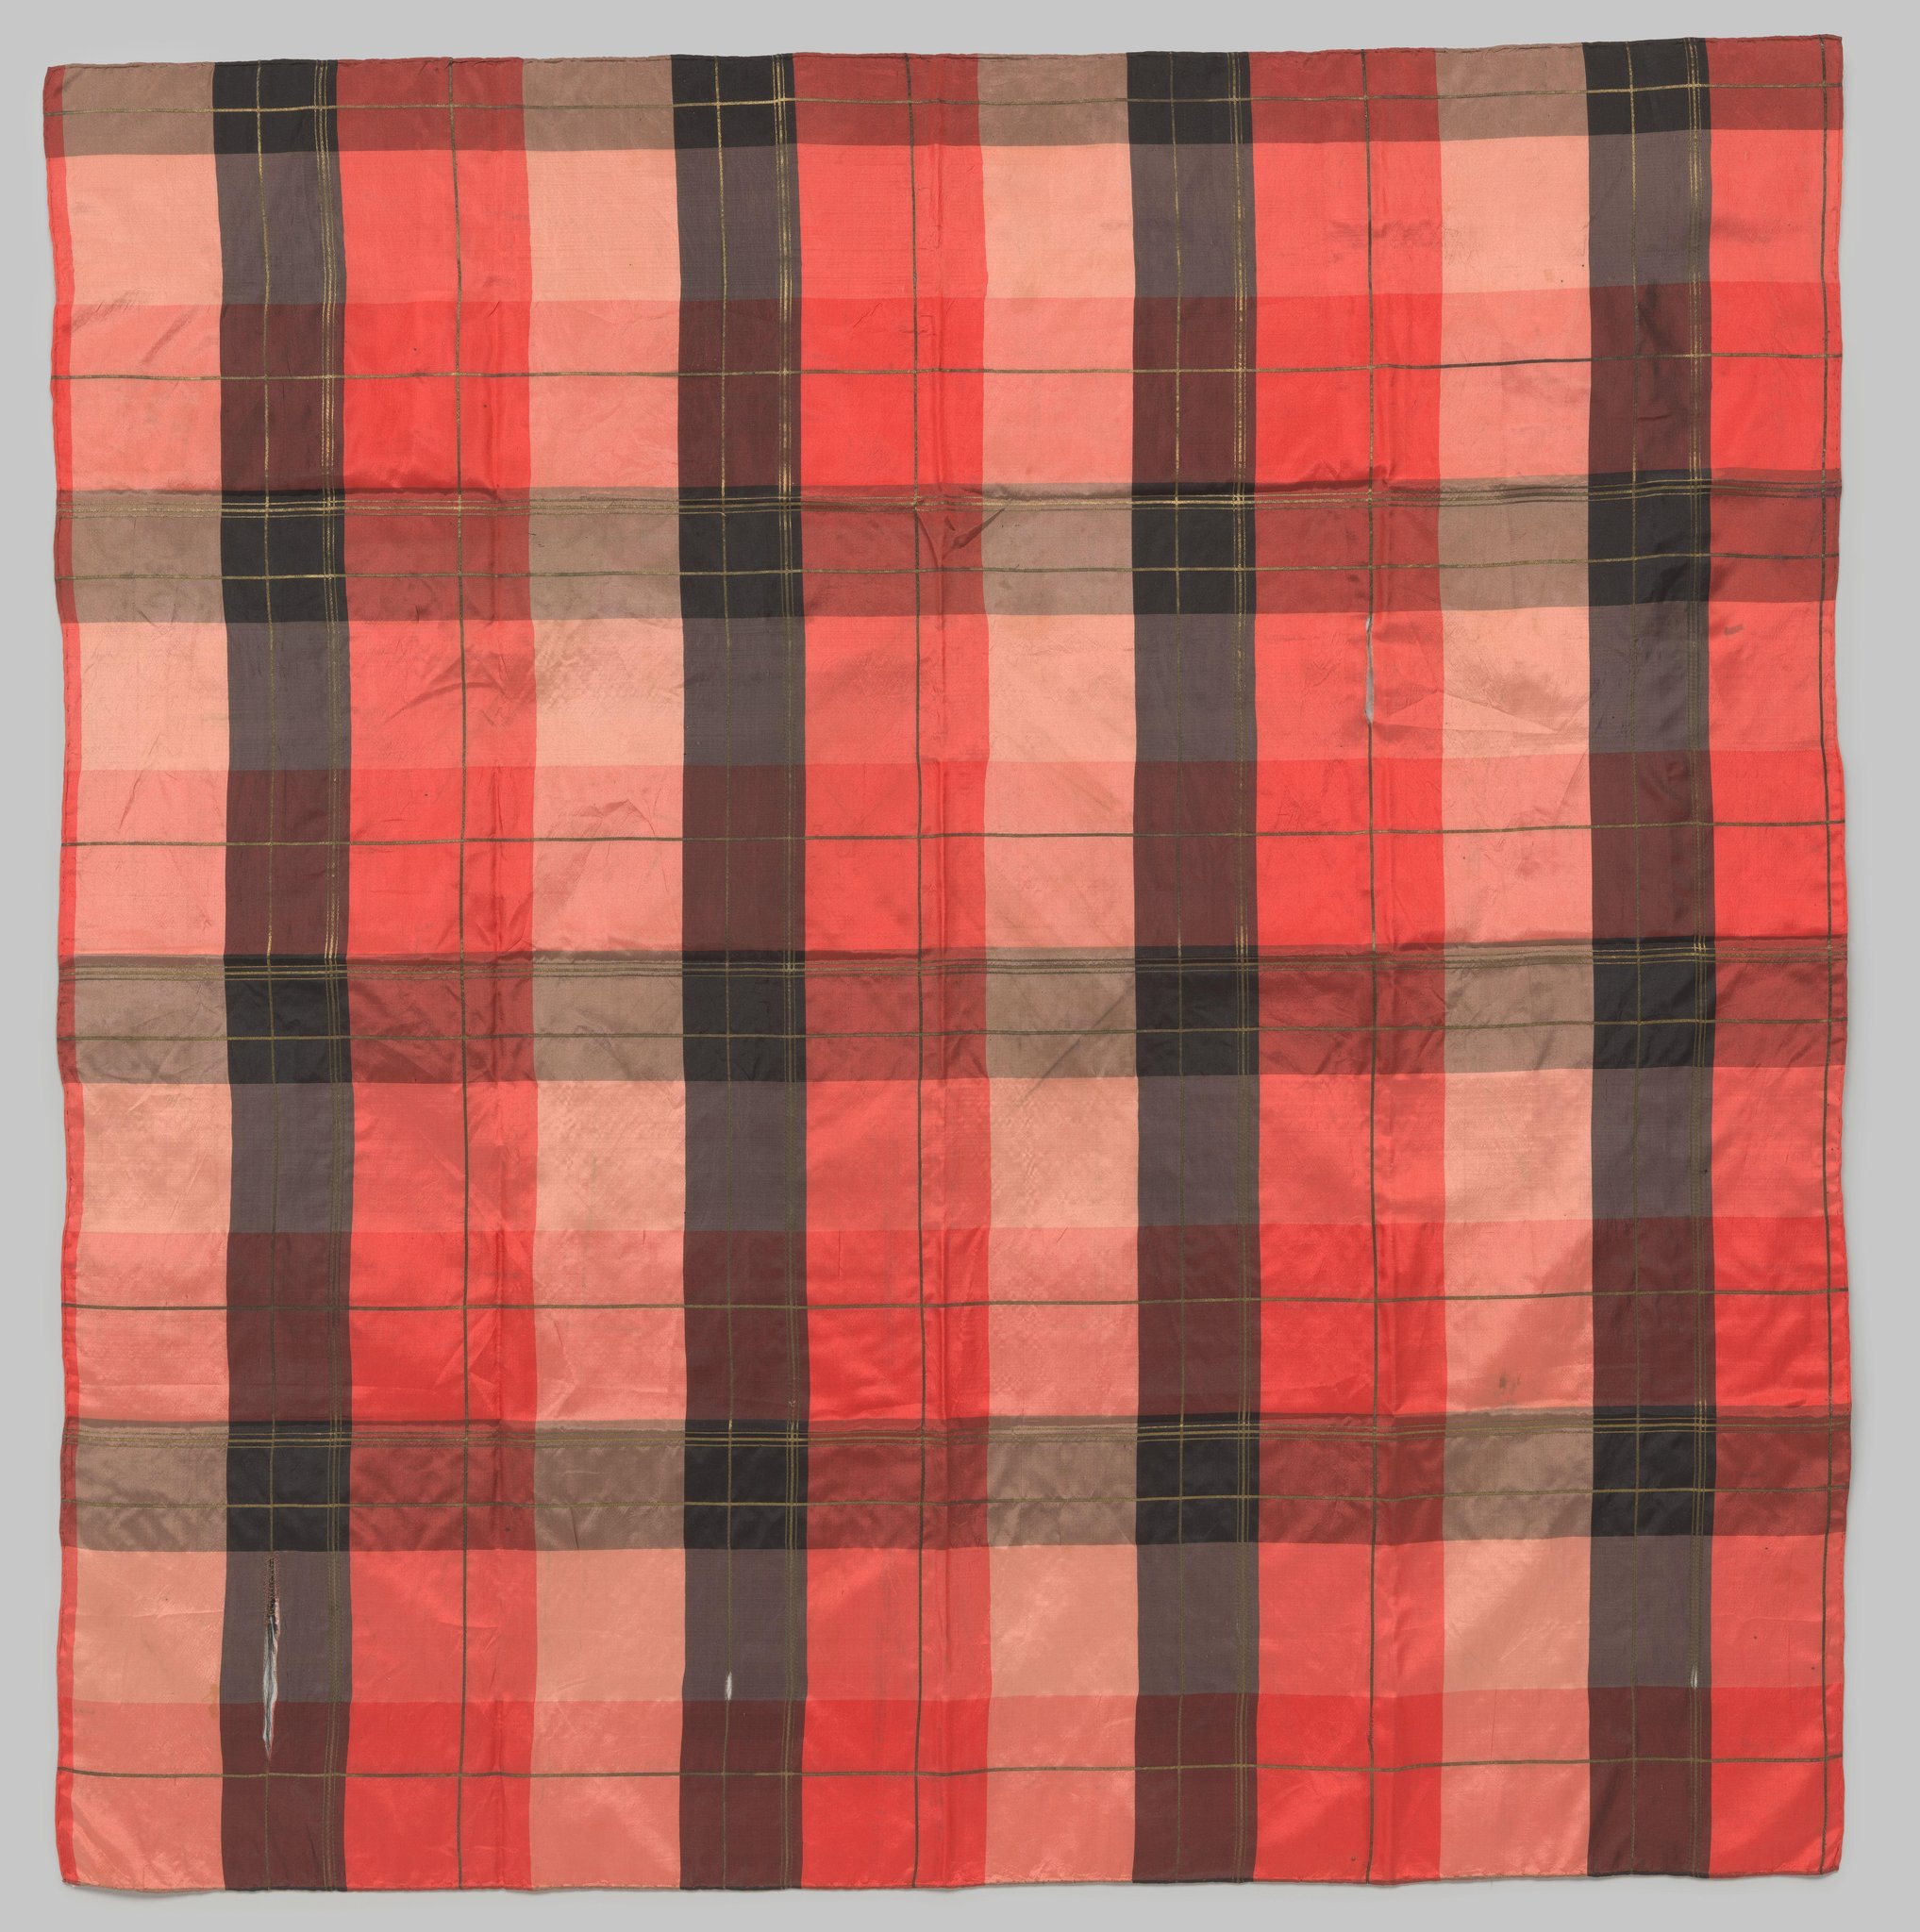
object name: clothing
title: Vierkante sjaal van rood-zwart- en goudgeruite tafzijde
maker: Anonymous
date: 1925-1950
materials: silk, textile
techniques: weave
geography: western europe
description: Vierkante sjaal van rood-zwart- en goudgeruite tafzijde. Blokpatroon door banen zwarte, roze en rode zijde, oversneden door gouden lijnen.